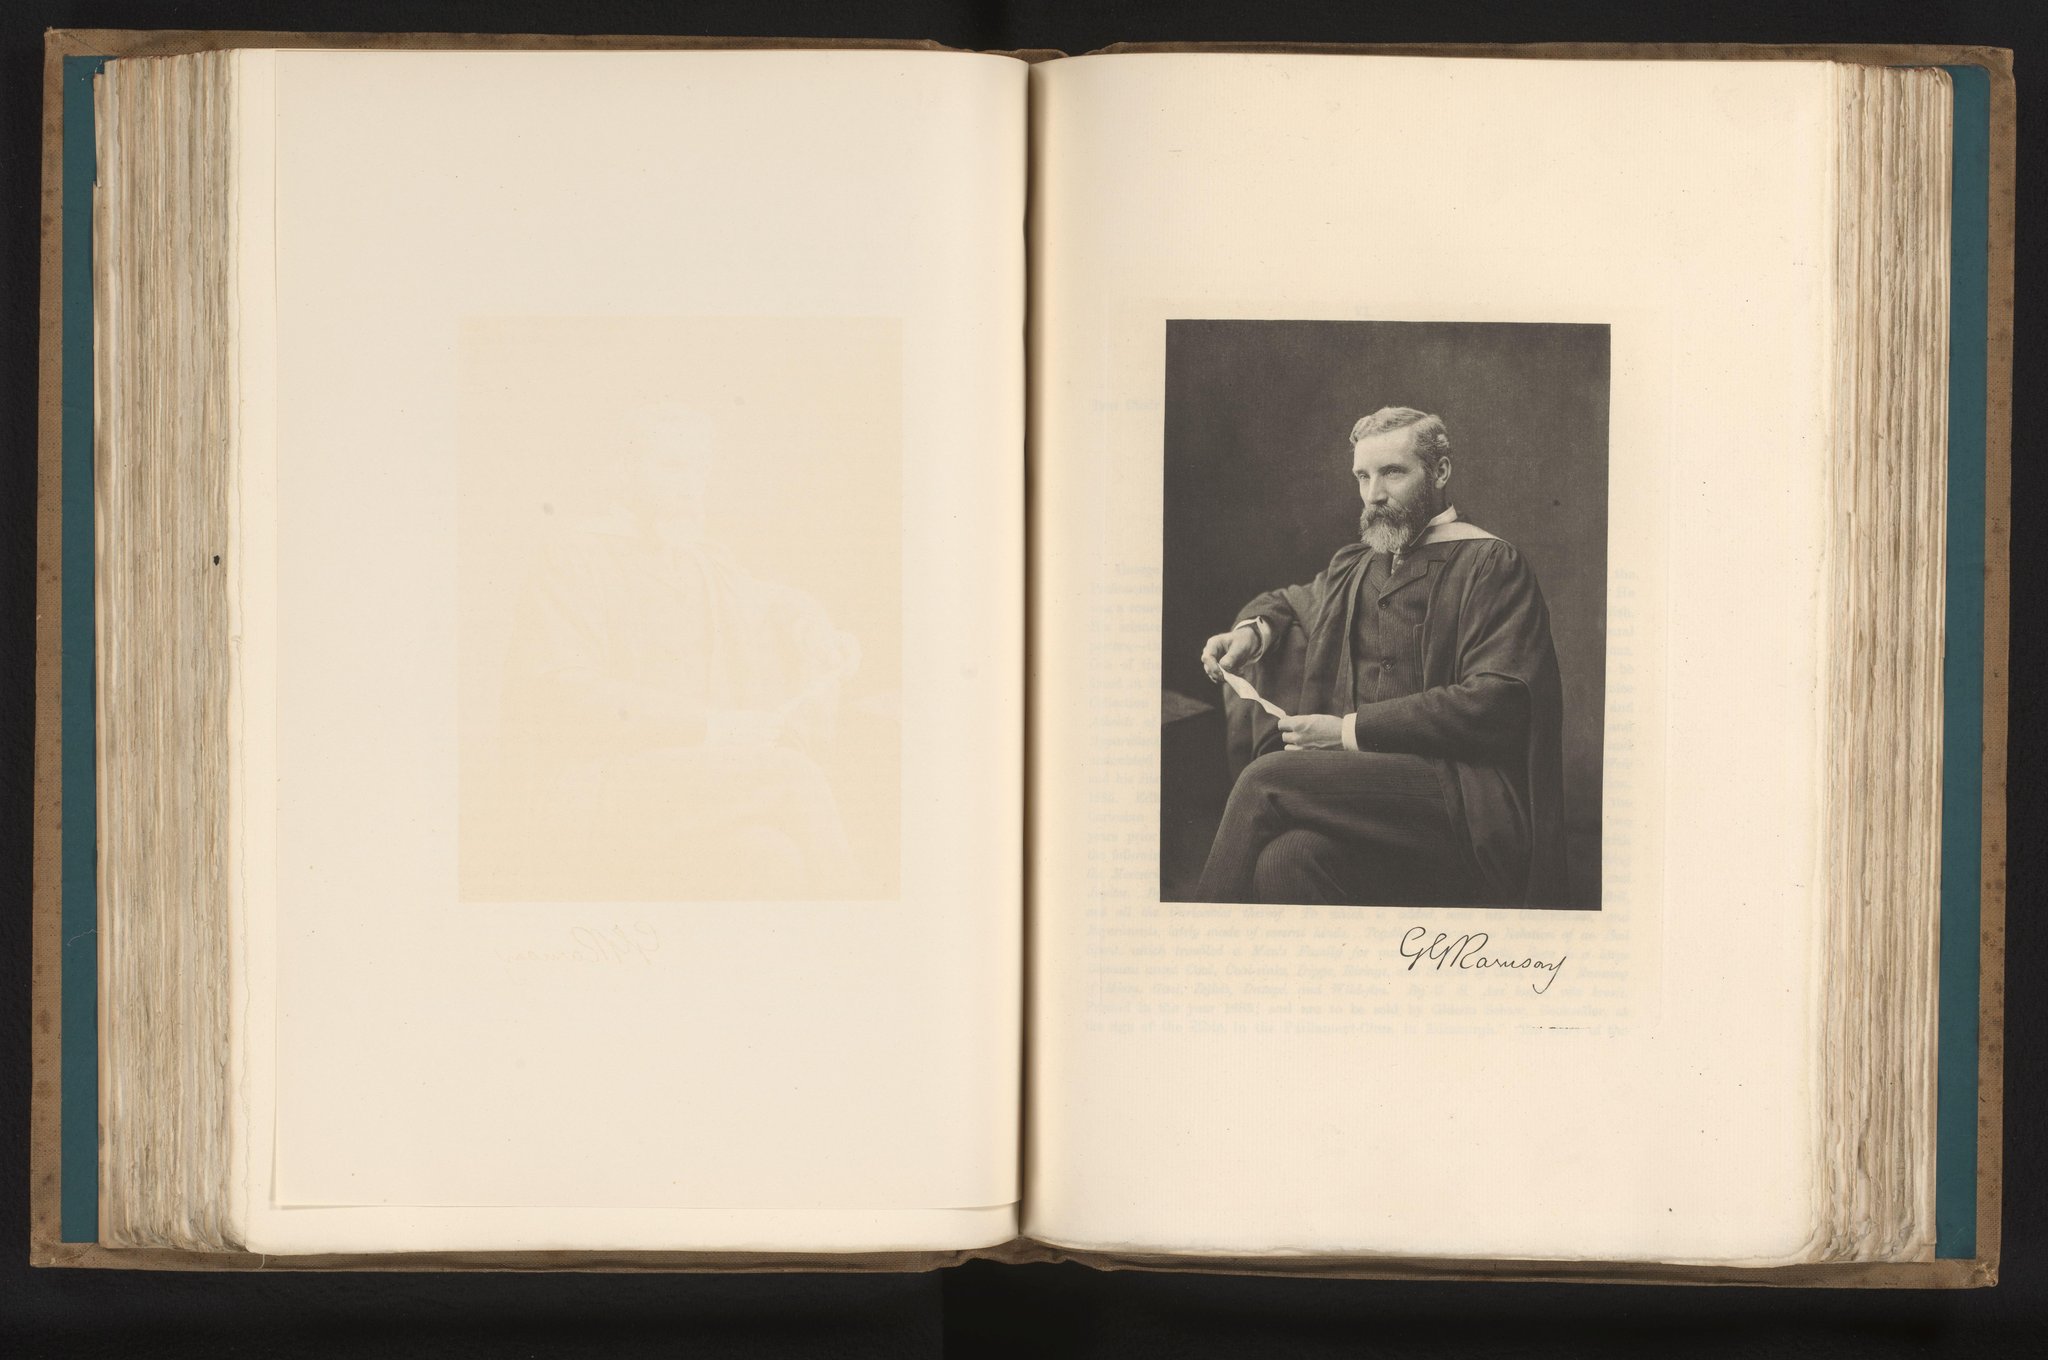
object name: page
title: G.G. Ramsay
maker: Anonymous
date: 1886-1891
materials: paper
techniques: photoaquatint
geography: glasgow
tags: historical persons, scholar, philosopher (+ portrait of scholar, scientist)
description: Prent op tweede ongenummerde pagina na pagina 59.